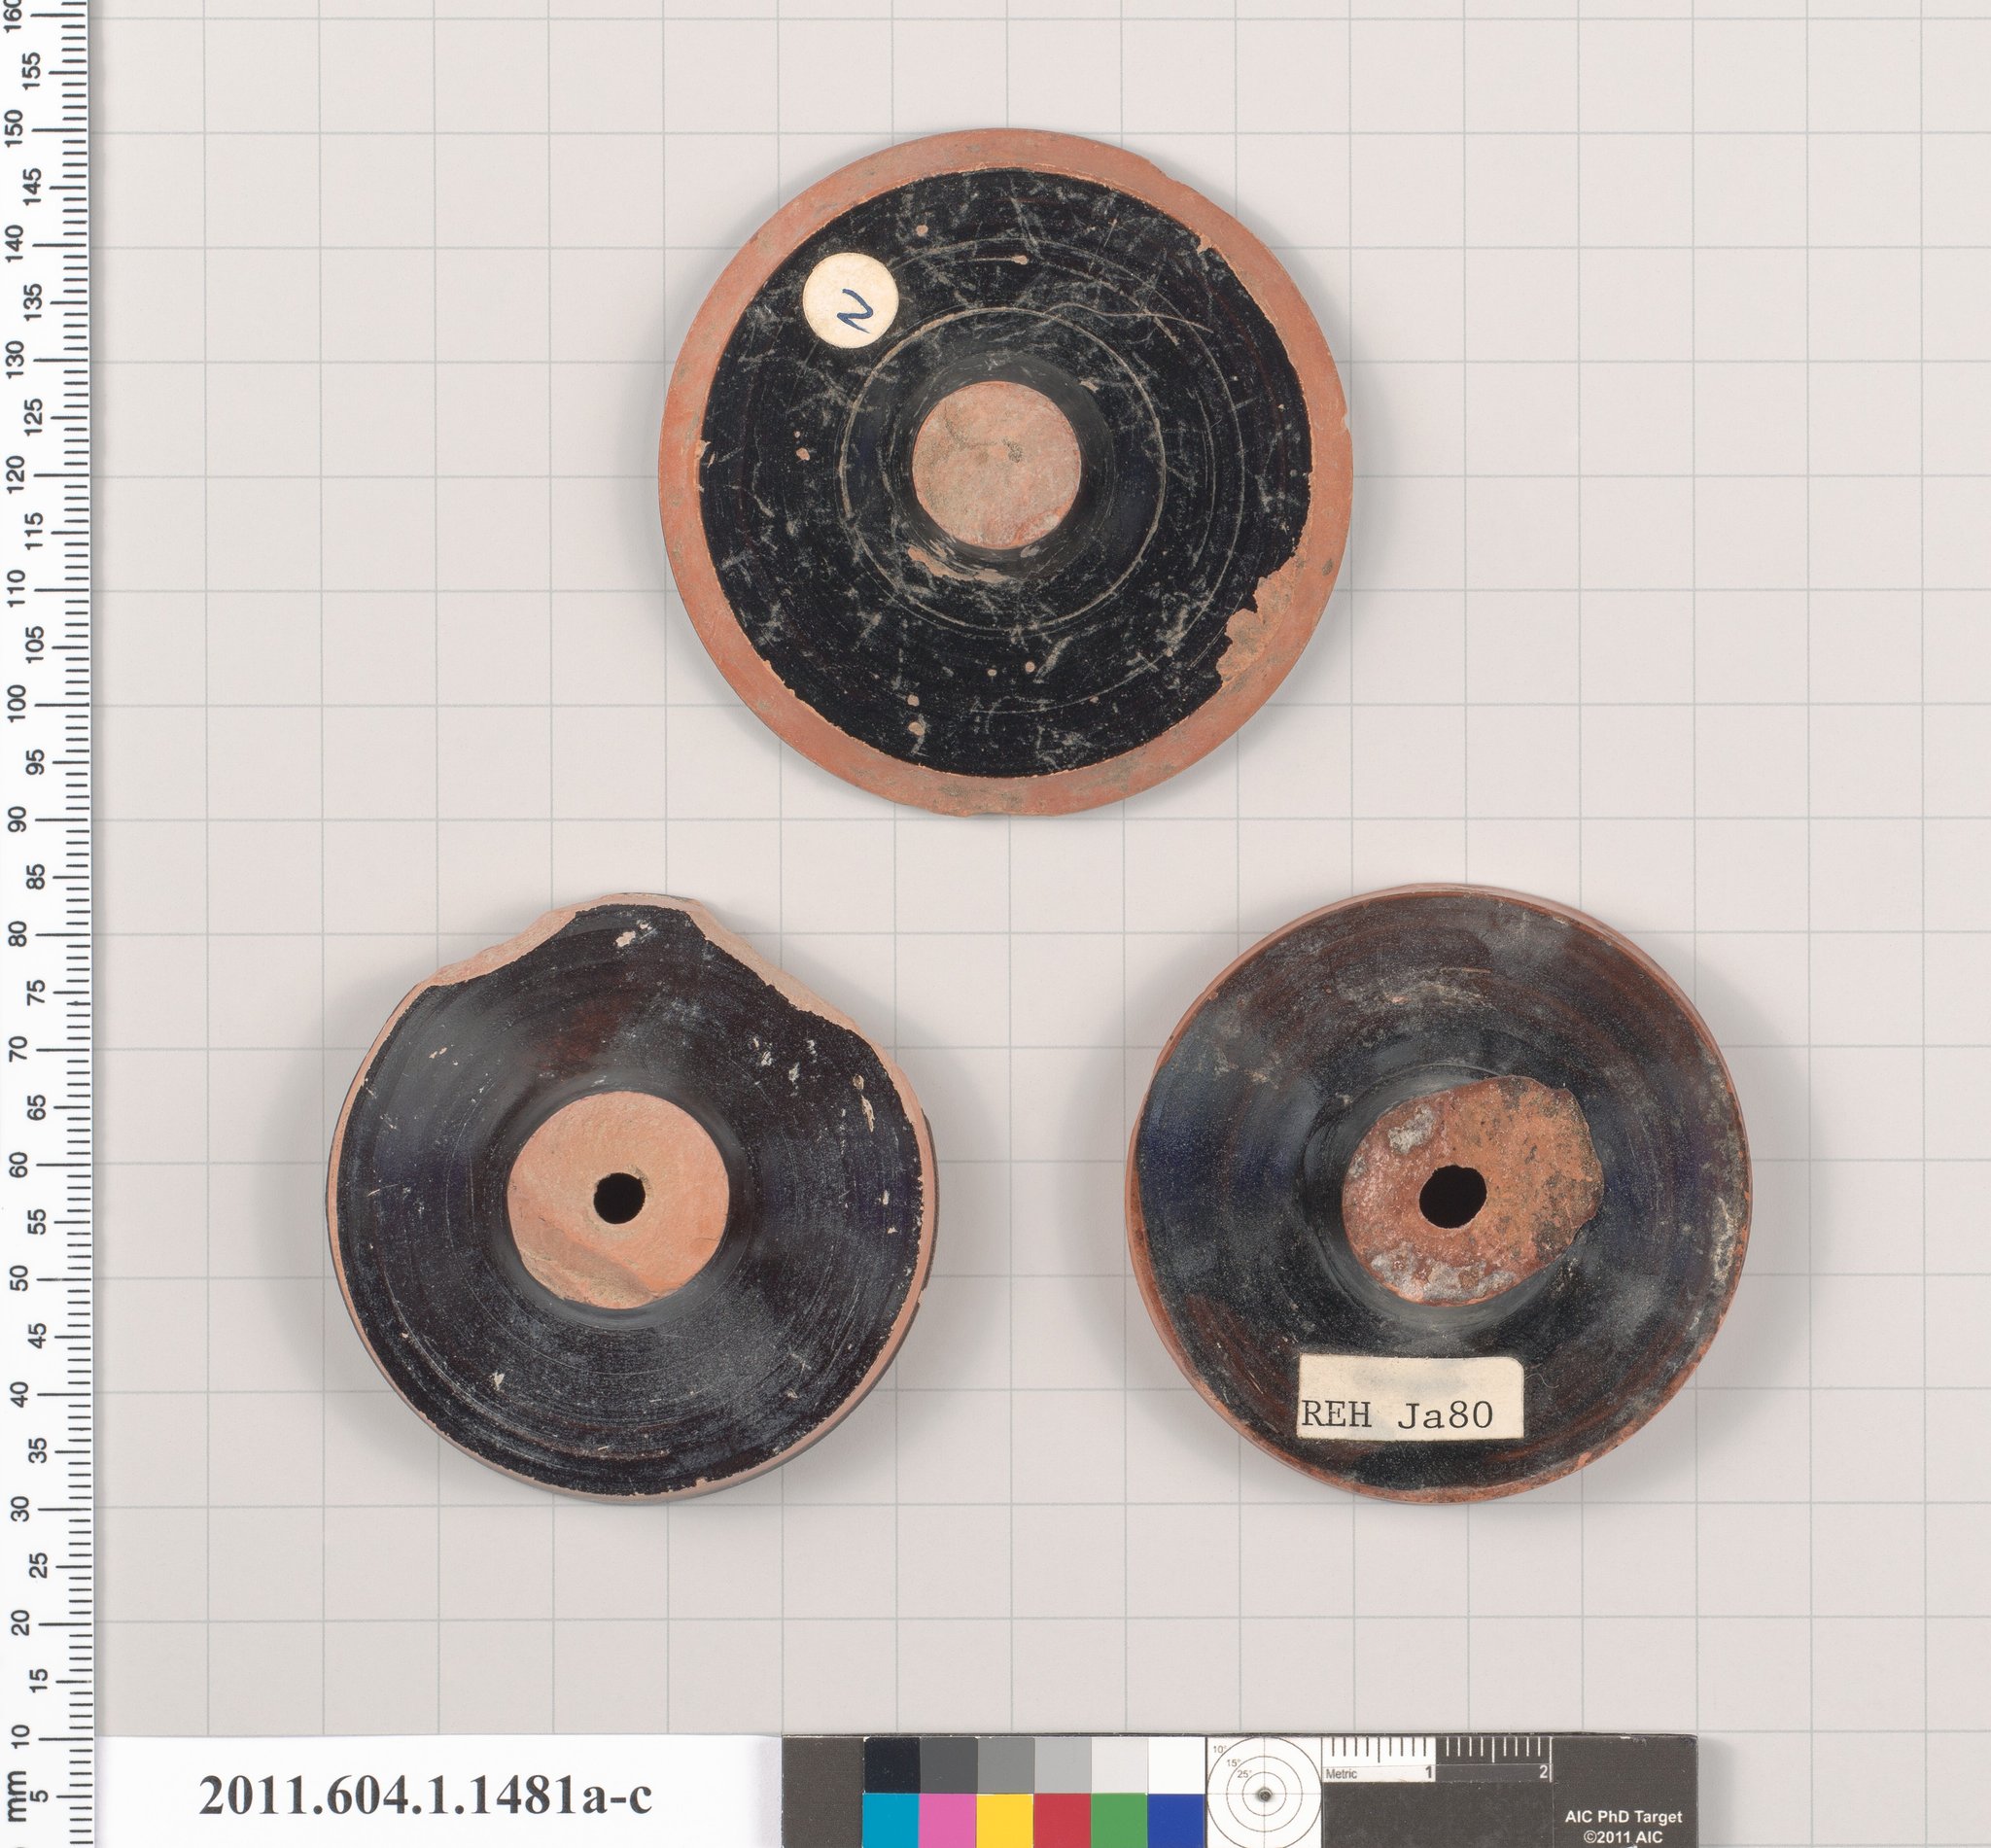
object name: kylix fragment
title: Terracotta fragments of kylikes (drinking cups)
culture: greek, attic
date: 500-401 BCE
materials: terracotta